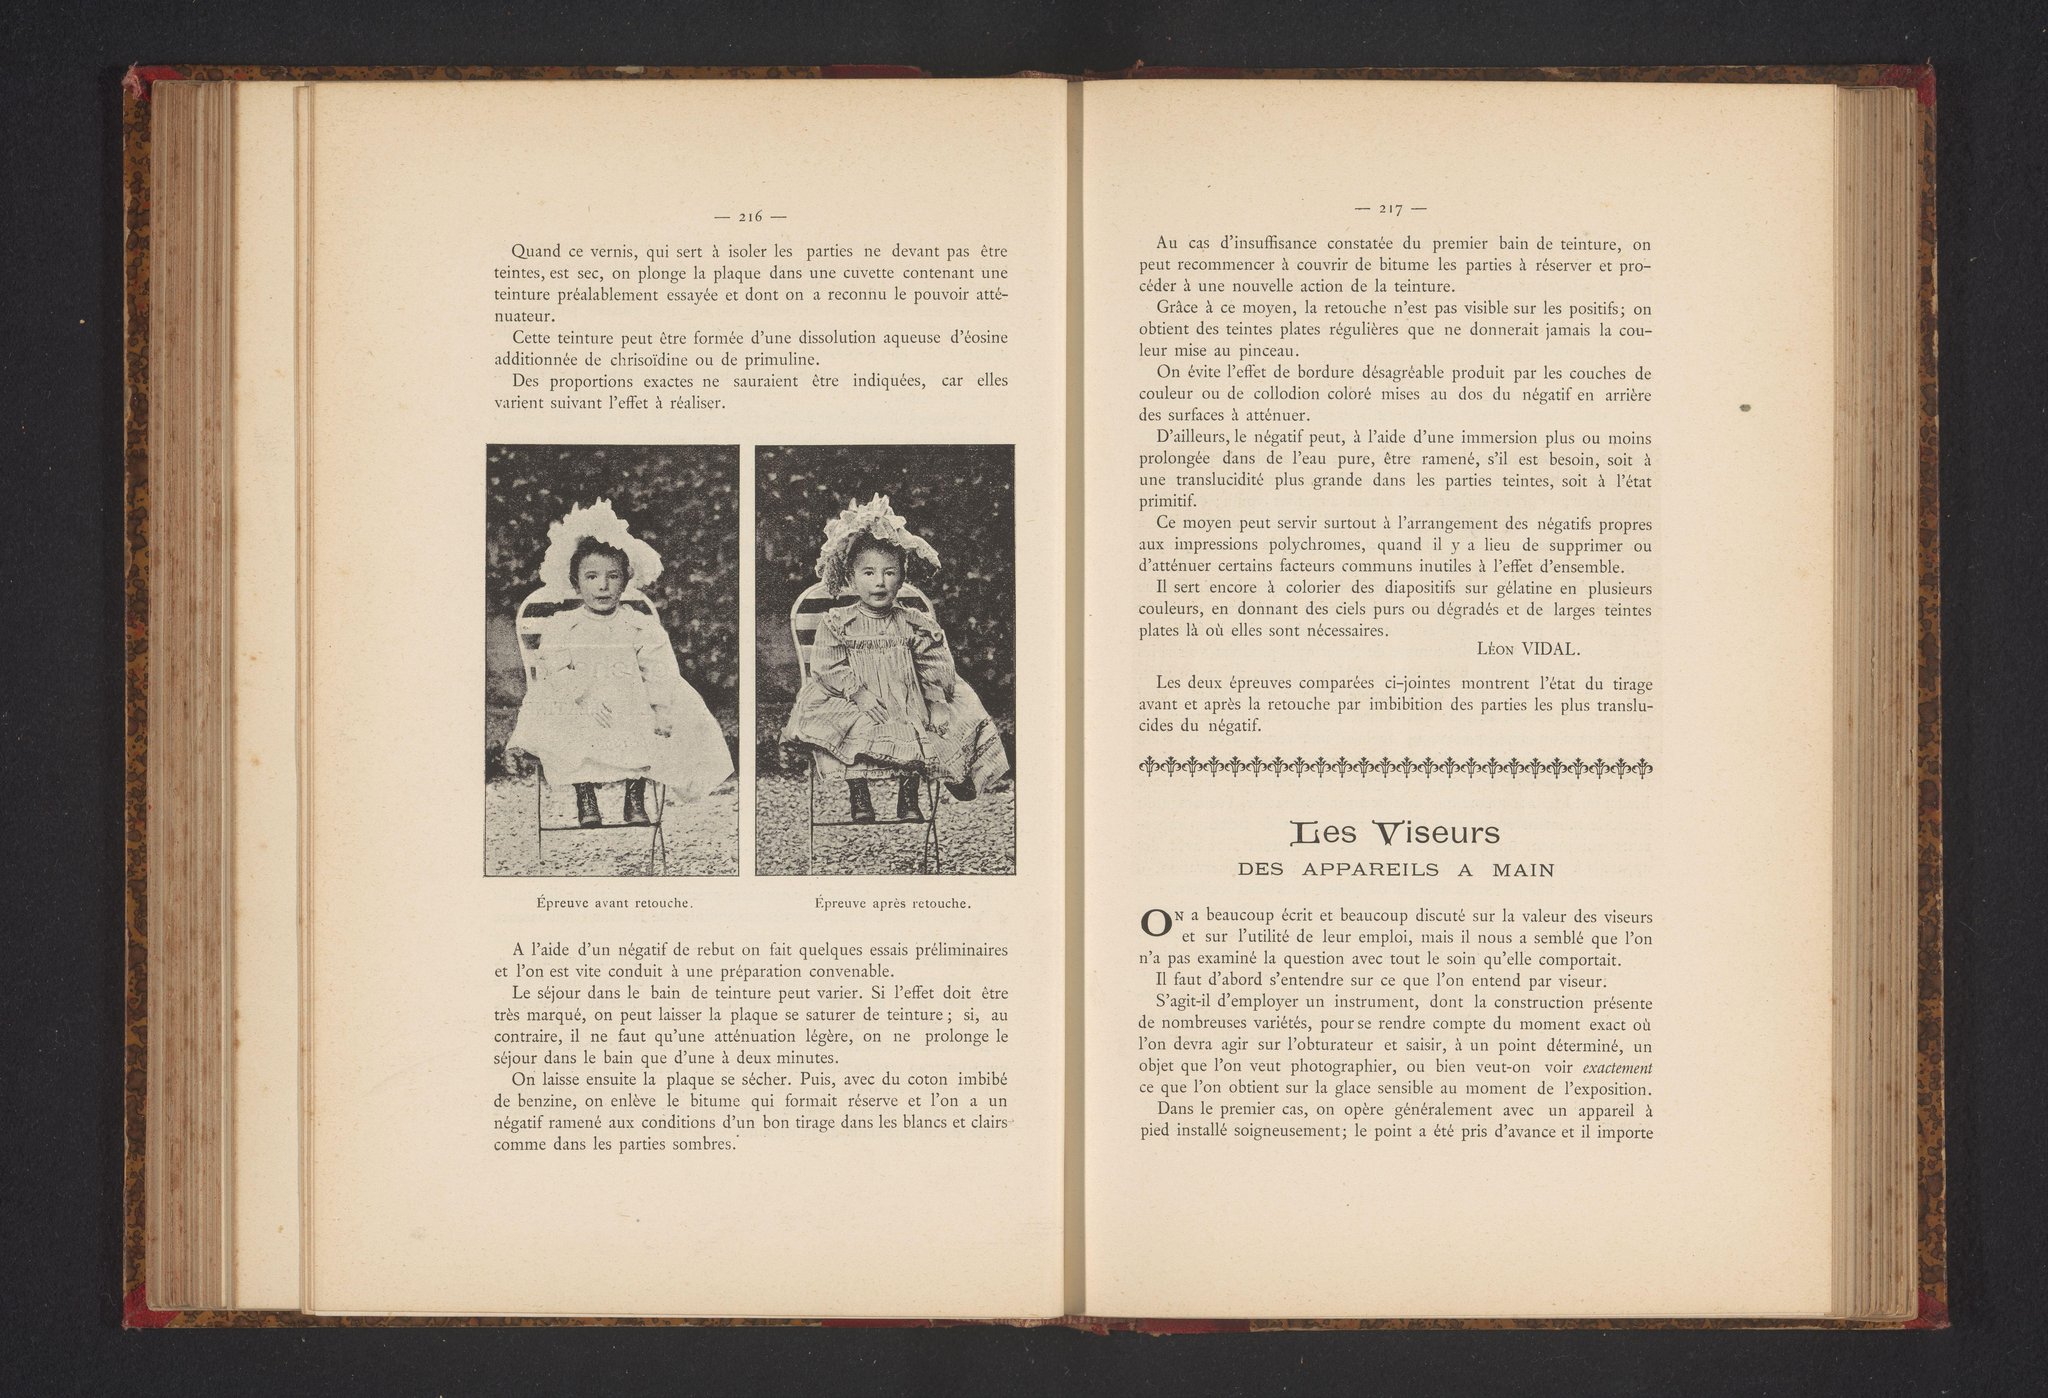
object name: photomechanical print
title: Portret van een onbekend meisje op een stoel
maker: Anonymous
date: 1888-1893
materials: paper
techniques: autotype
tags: historical persons not known by name - bb - woman, toddler (female), chair